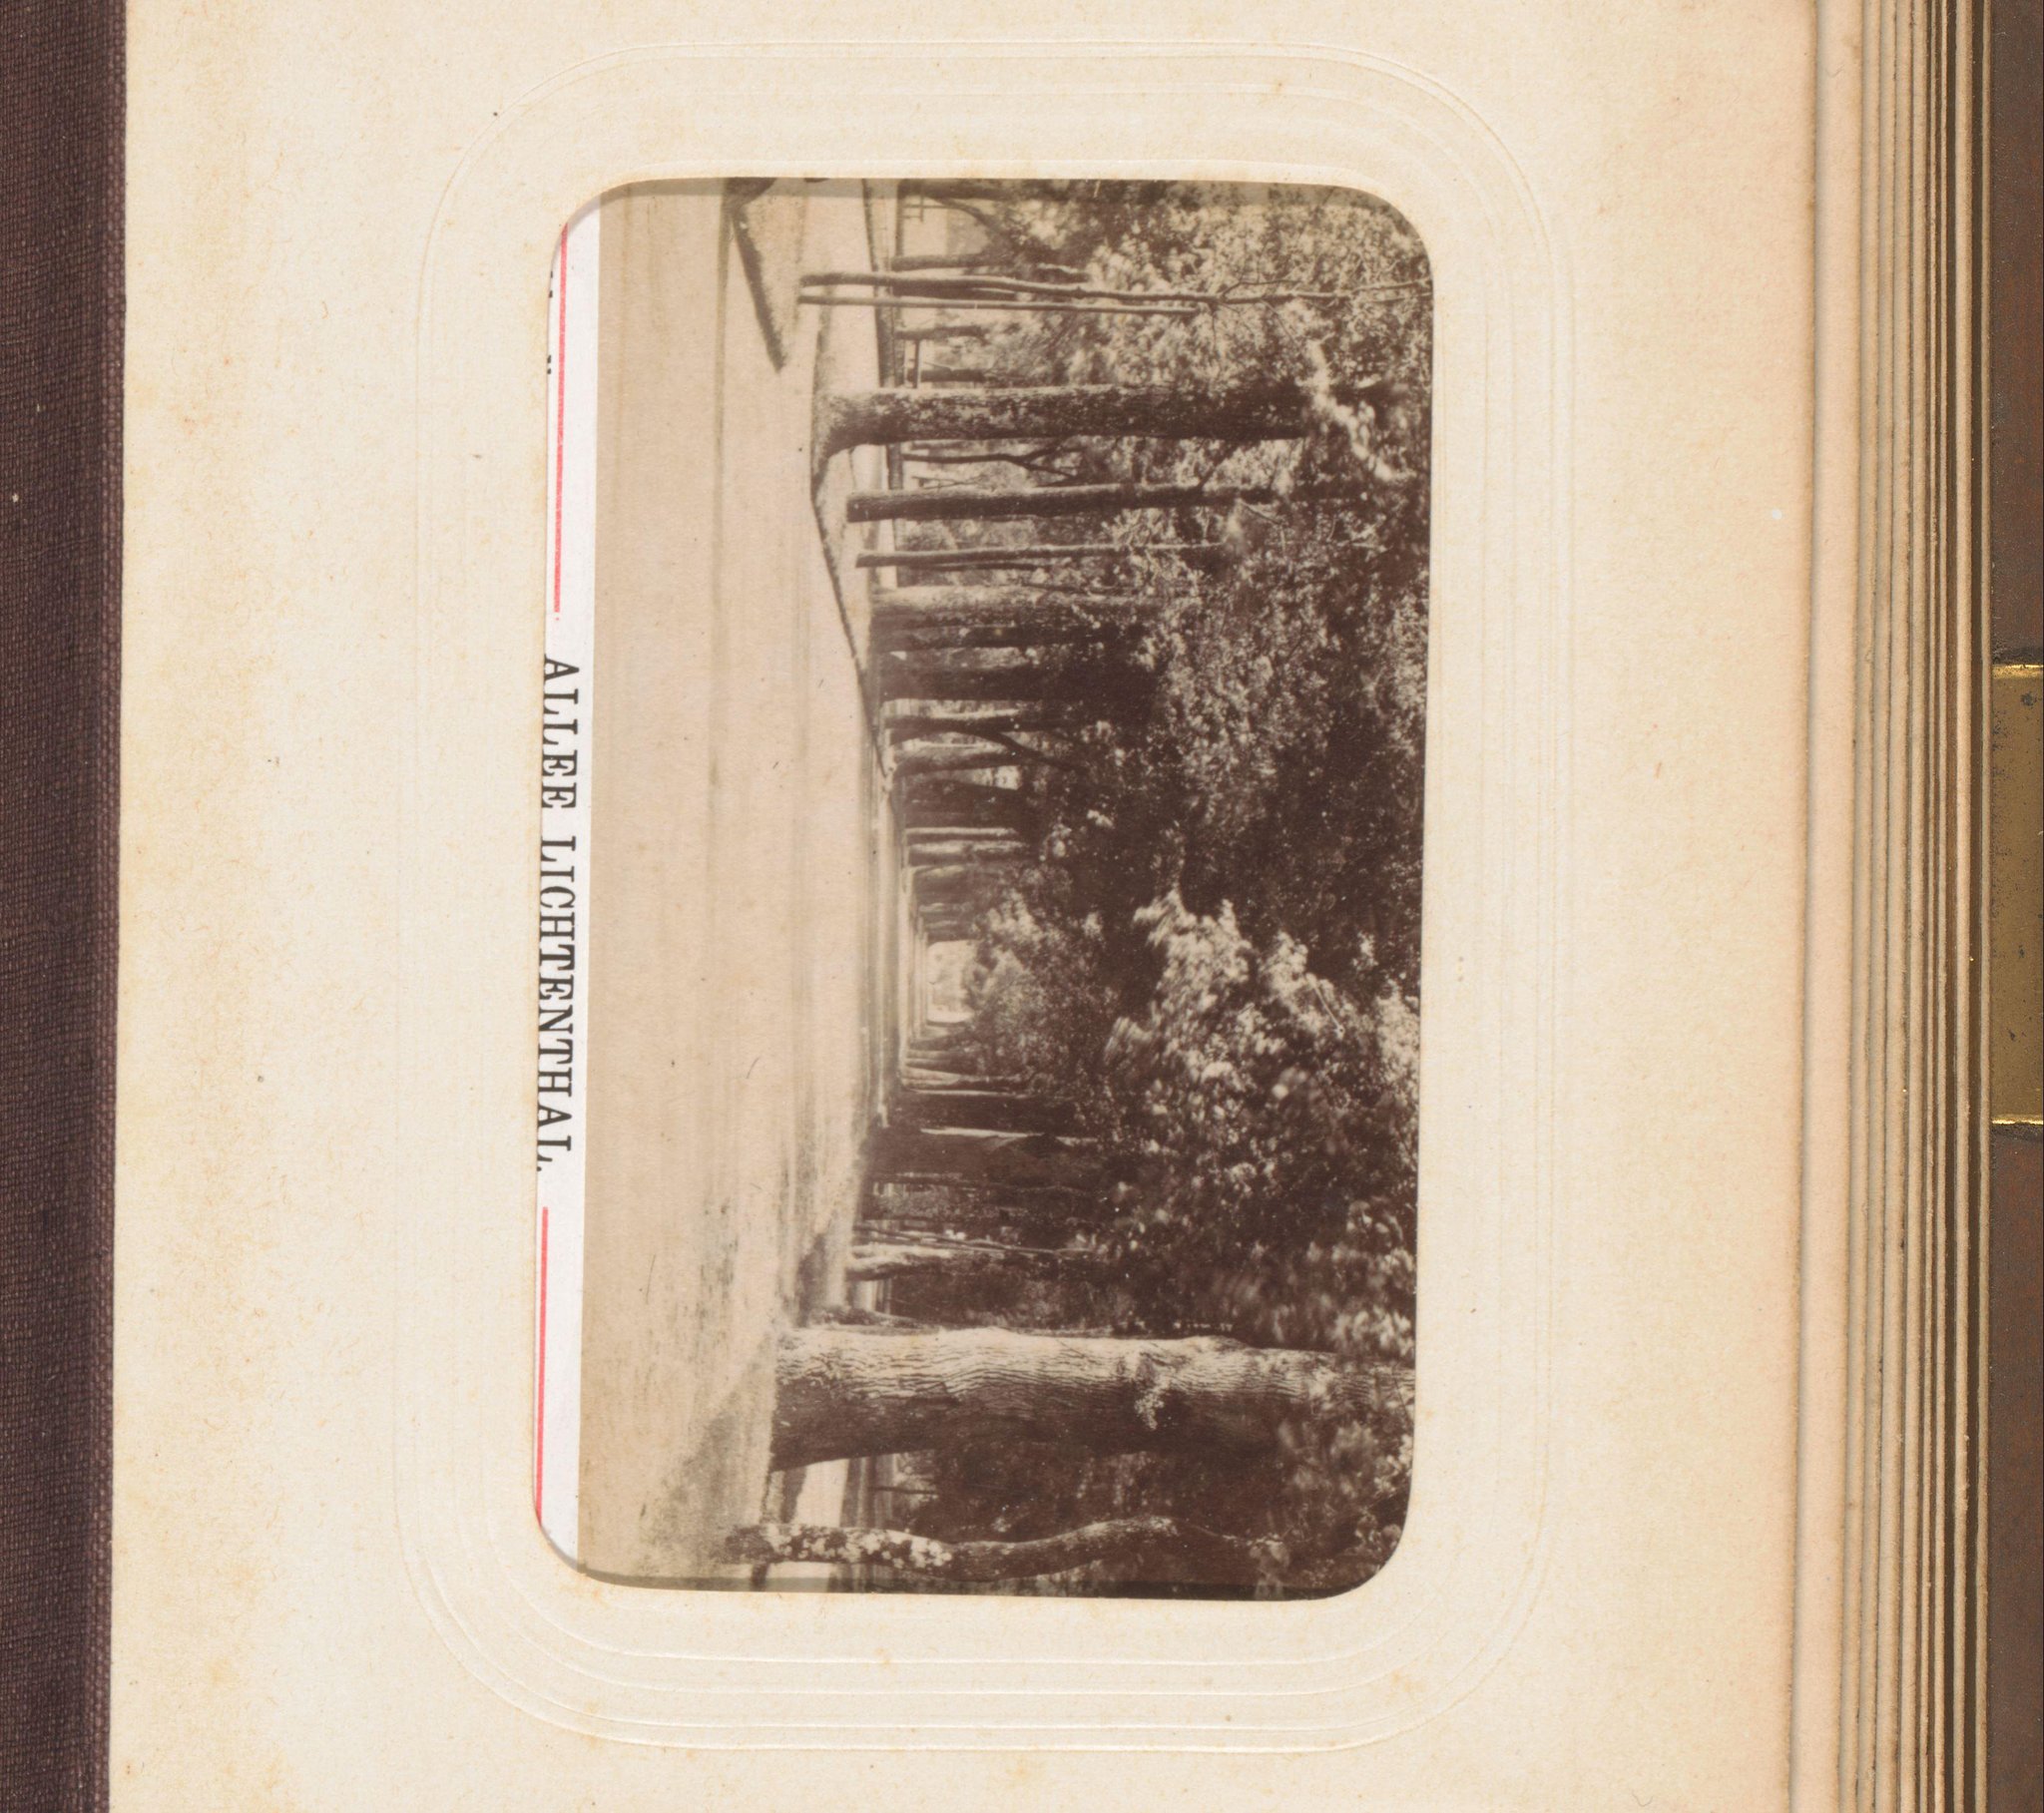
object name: album leaf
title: Pad in Lichtentaler Allee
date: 1870-1900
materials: cardboard, photographic support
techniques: albumen print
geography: baden-baden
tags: park, trees, lane, alley